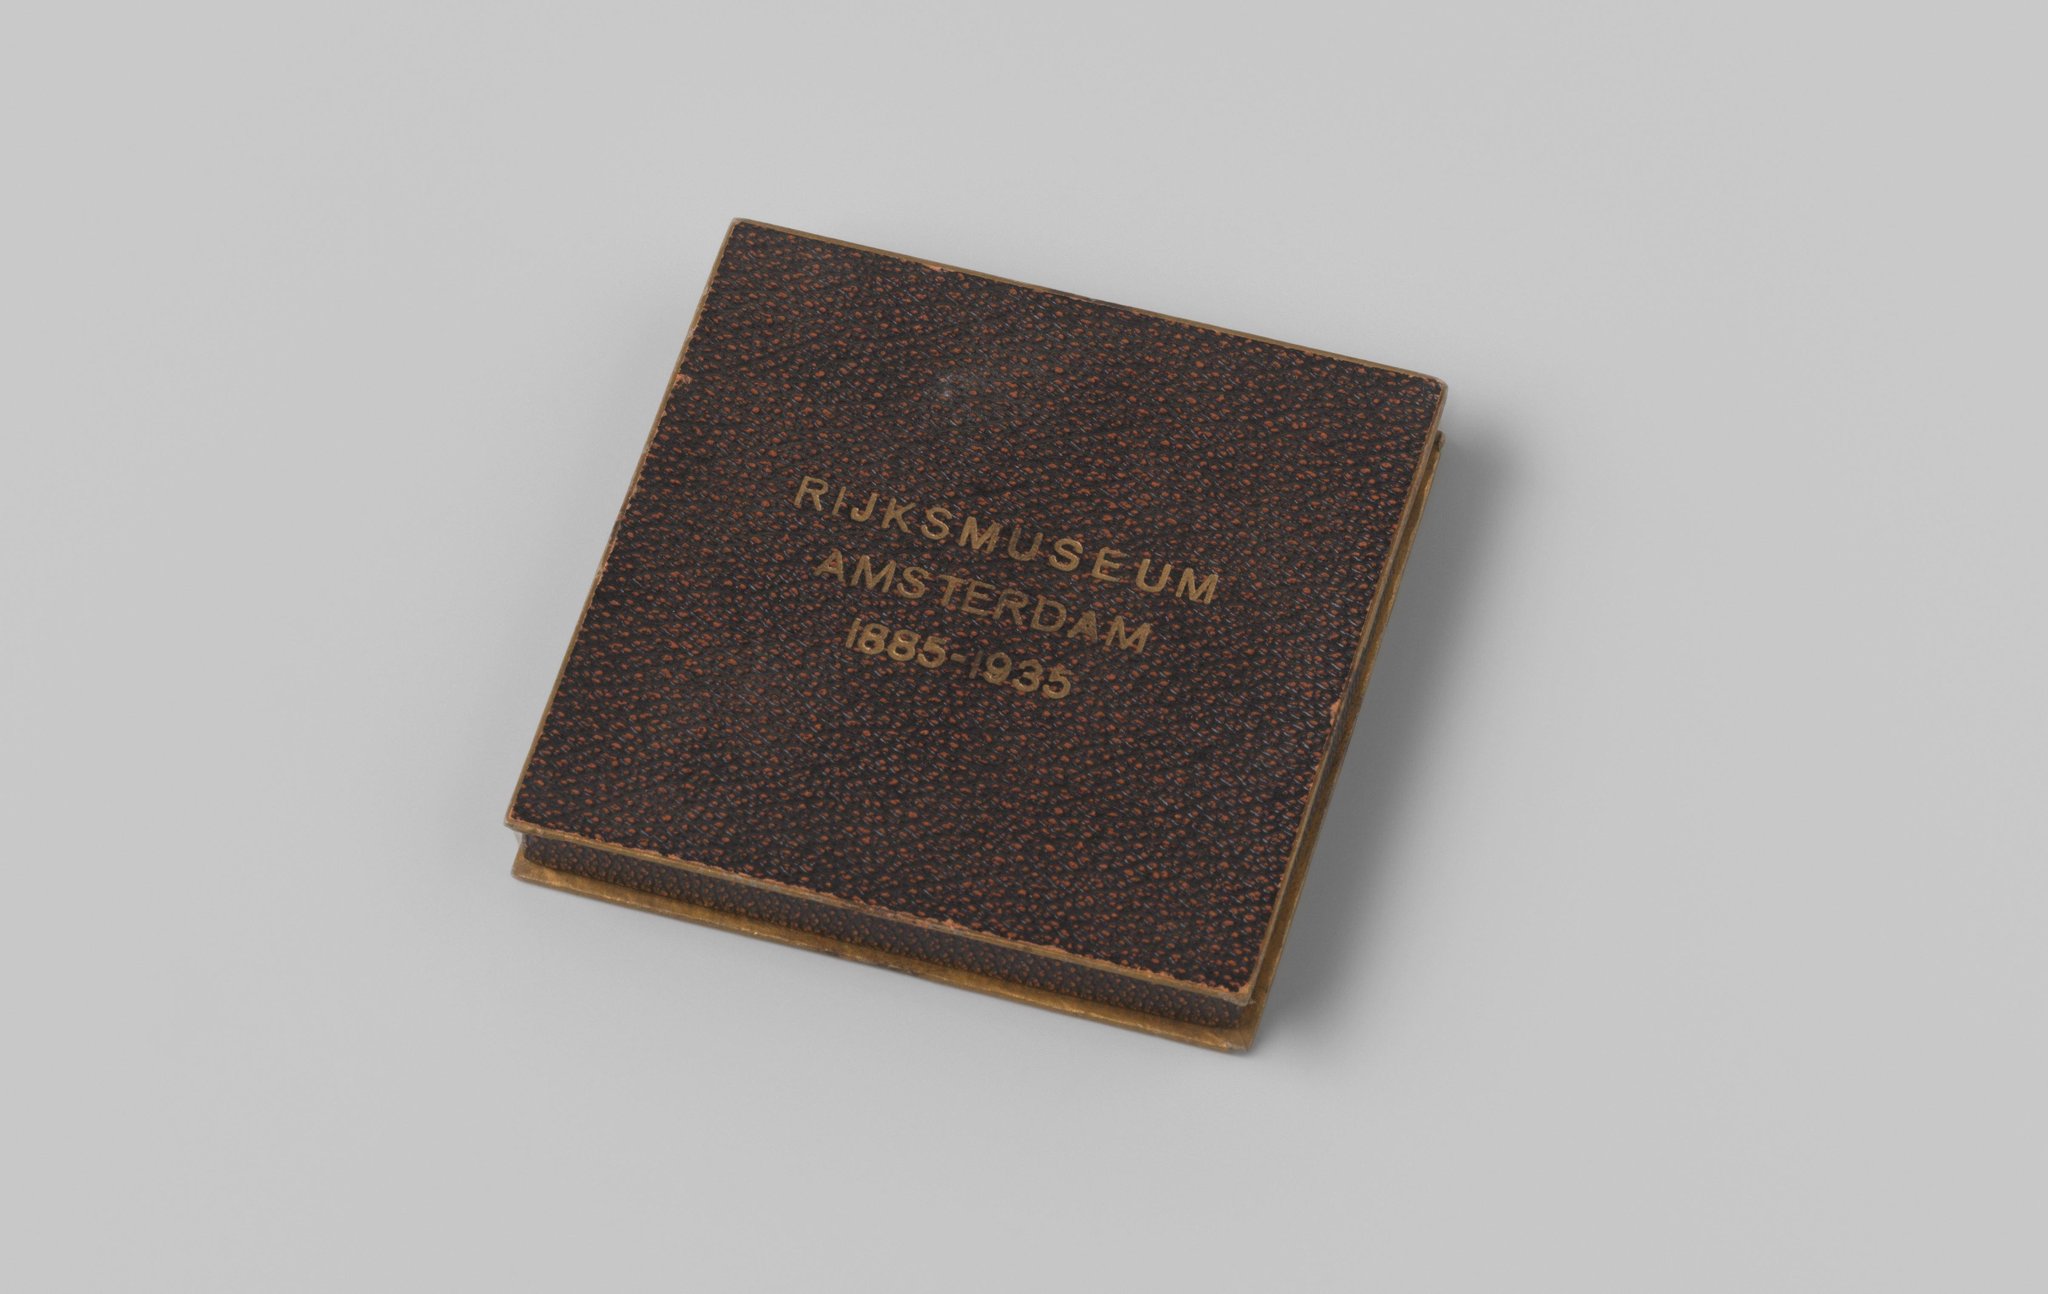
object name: box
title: Doosje behorend bij een bronzen penning ter ere van het vijftigjarig bestaan van het Rijksmuseum te Amsterdam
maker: dirk bus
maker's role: sculptor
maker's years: 1907-1978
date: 1935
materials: leather, velvet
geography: the hague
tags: rijksmuseum amsterdam, amsterdam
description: Vierkant doosje van leer. Op de deksel staat Rijksmuseum Amsterdam 1885-1935. De randen zijn goudkleurig, binnnzijde is van rood-bruin fluweel.